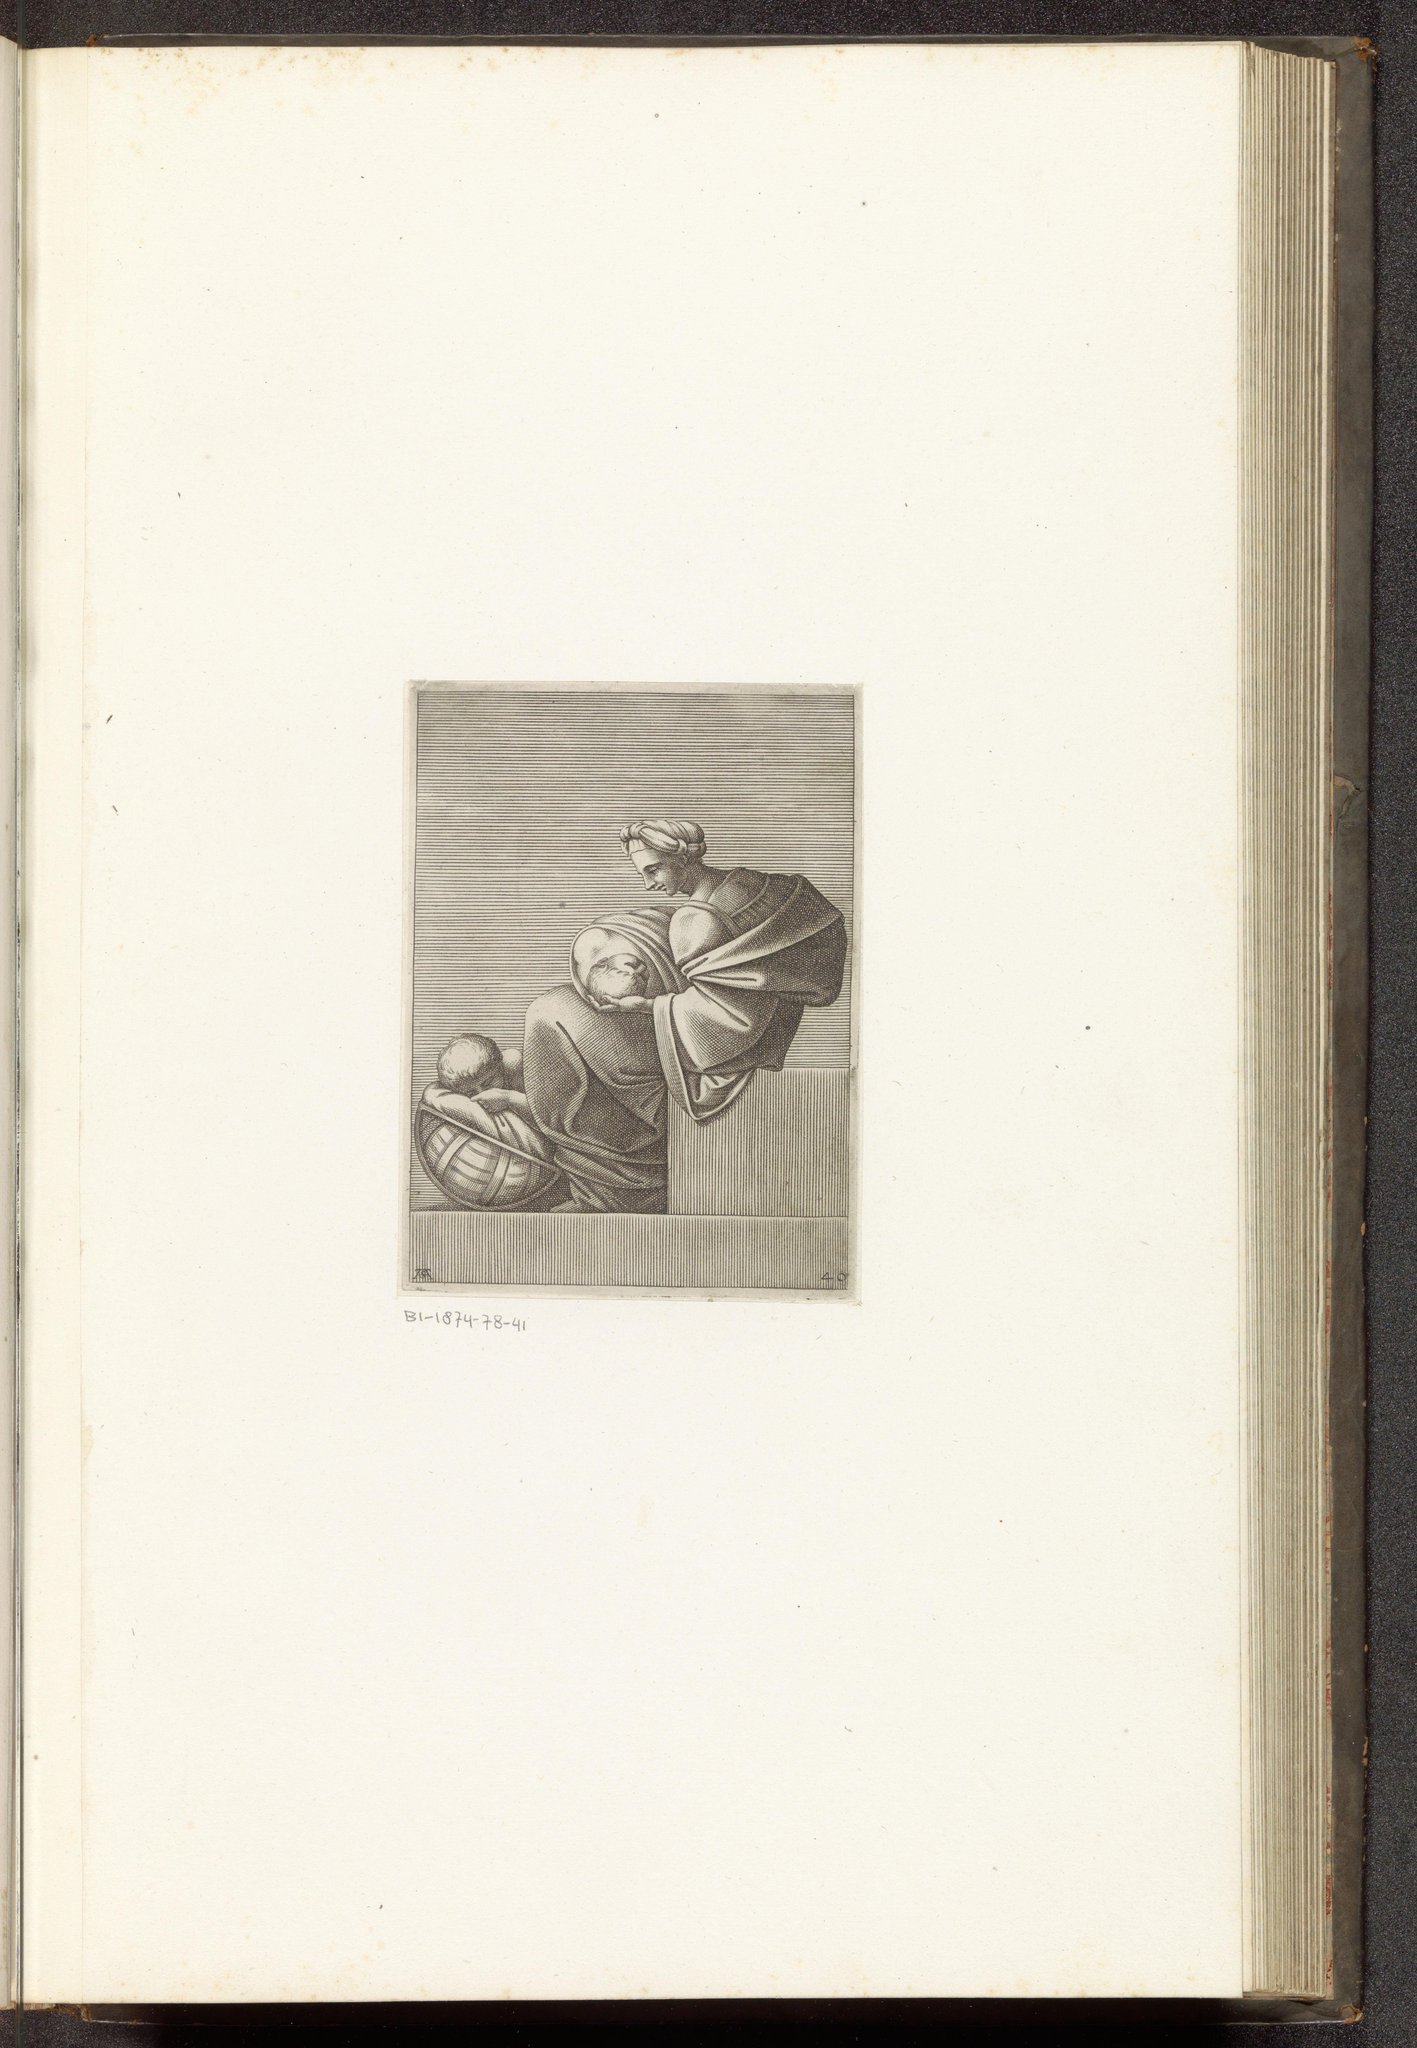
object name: album leaf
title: Schilderingen in de Sixtijnse kapel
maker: adamo scultori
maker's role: painter, print maker, sculptor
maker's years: 1530-1585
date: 1585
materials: paper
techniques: engraving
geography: italy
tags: sleeping; unconsciousness, mother and child(ren), woman and child(ren) (family group)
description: Deze prent maakt deel uit van een serie bestaande uit een titelprent en 72 prenten naar schilderingen door Michelangelo in de Sixtijnse Kapel in het Vaticaan.